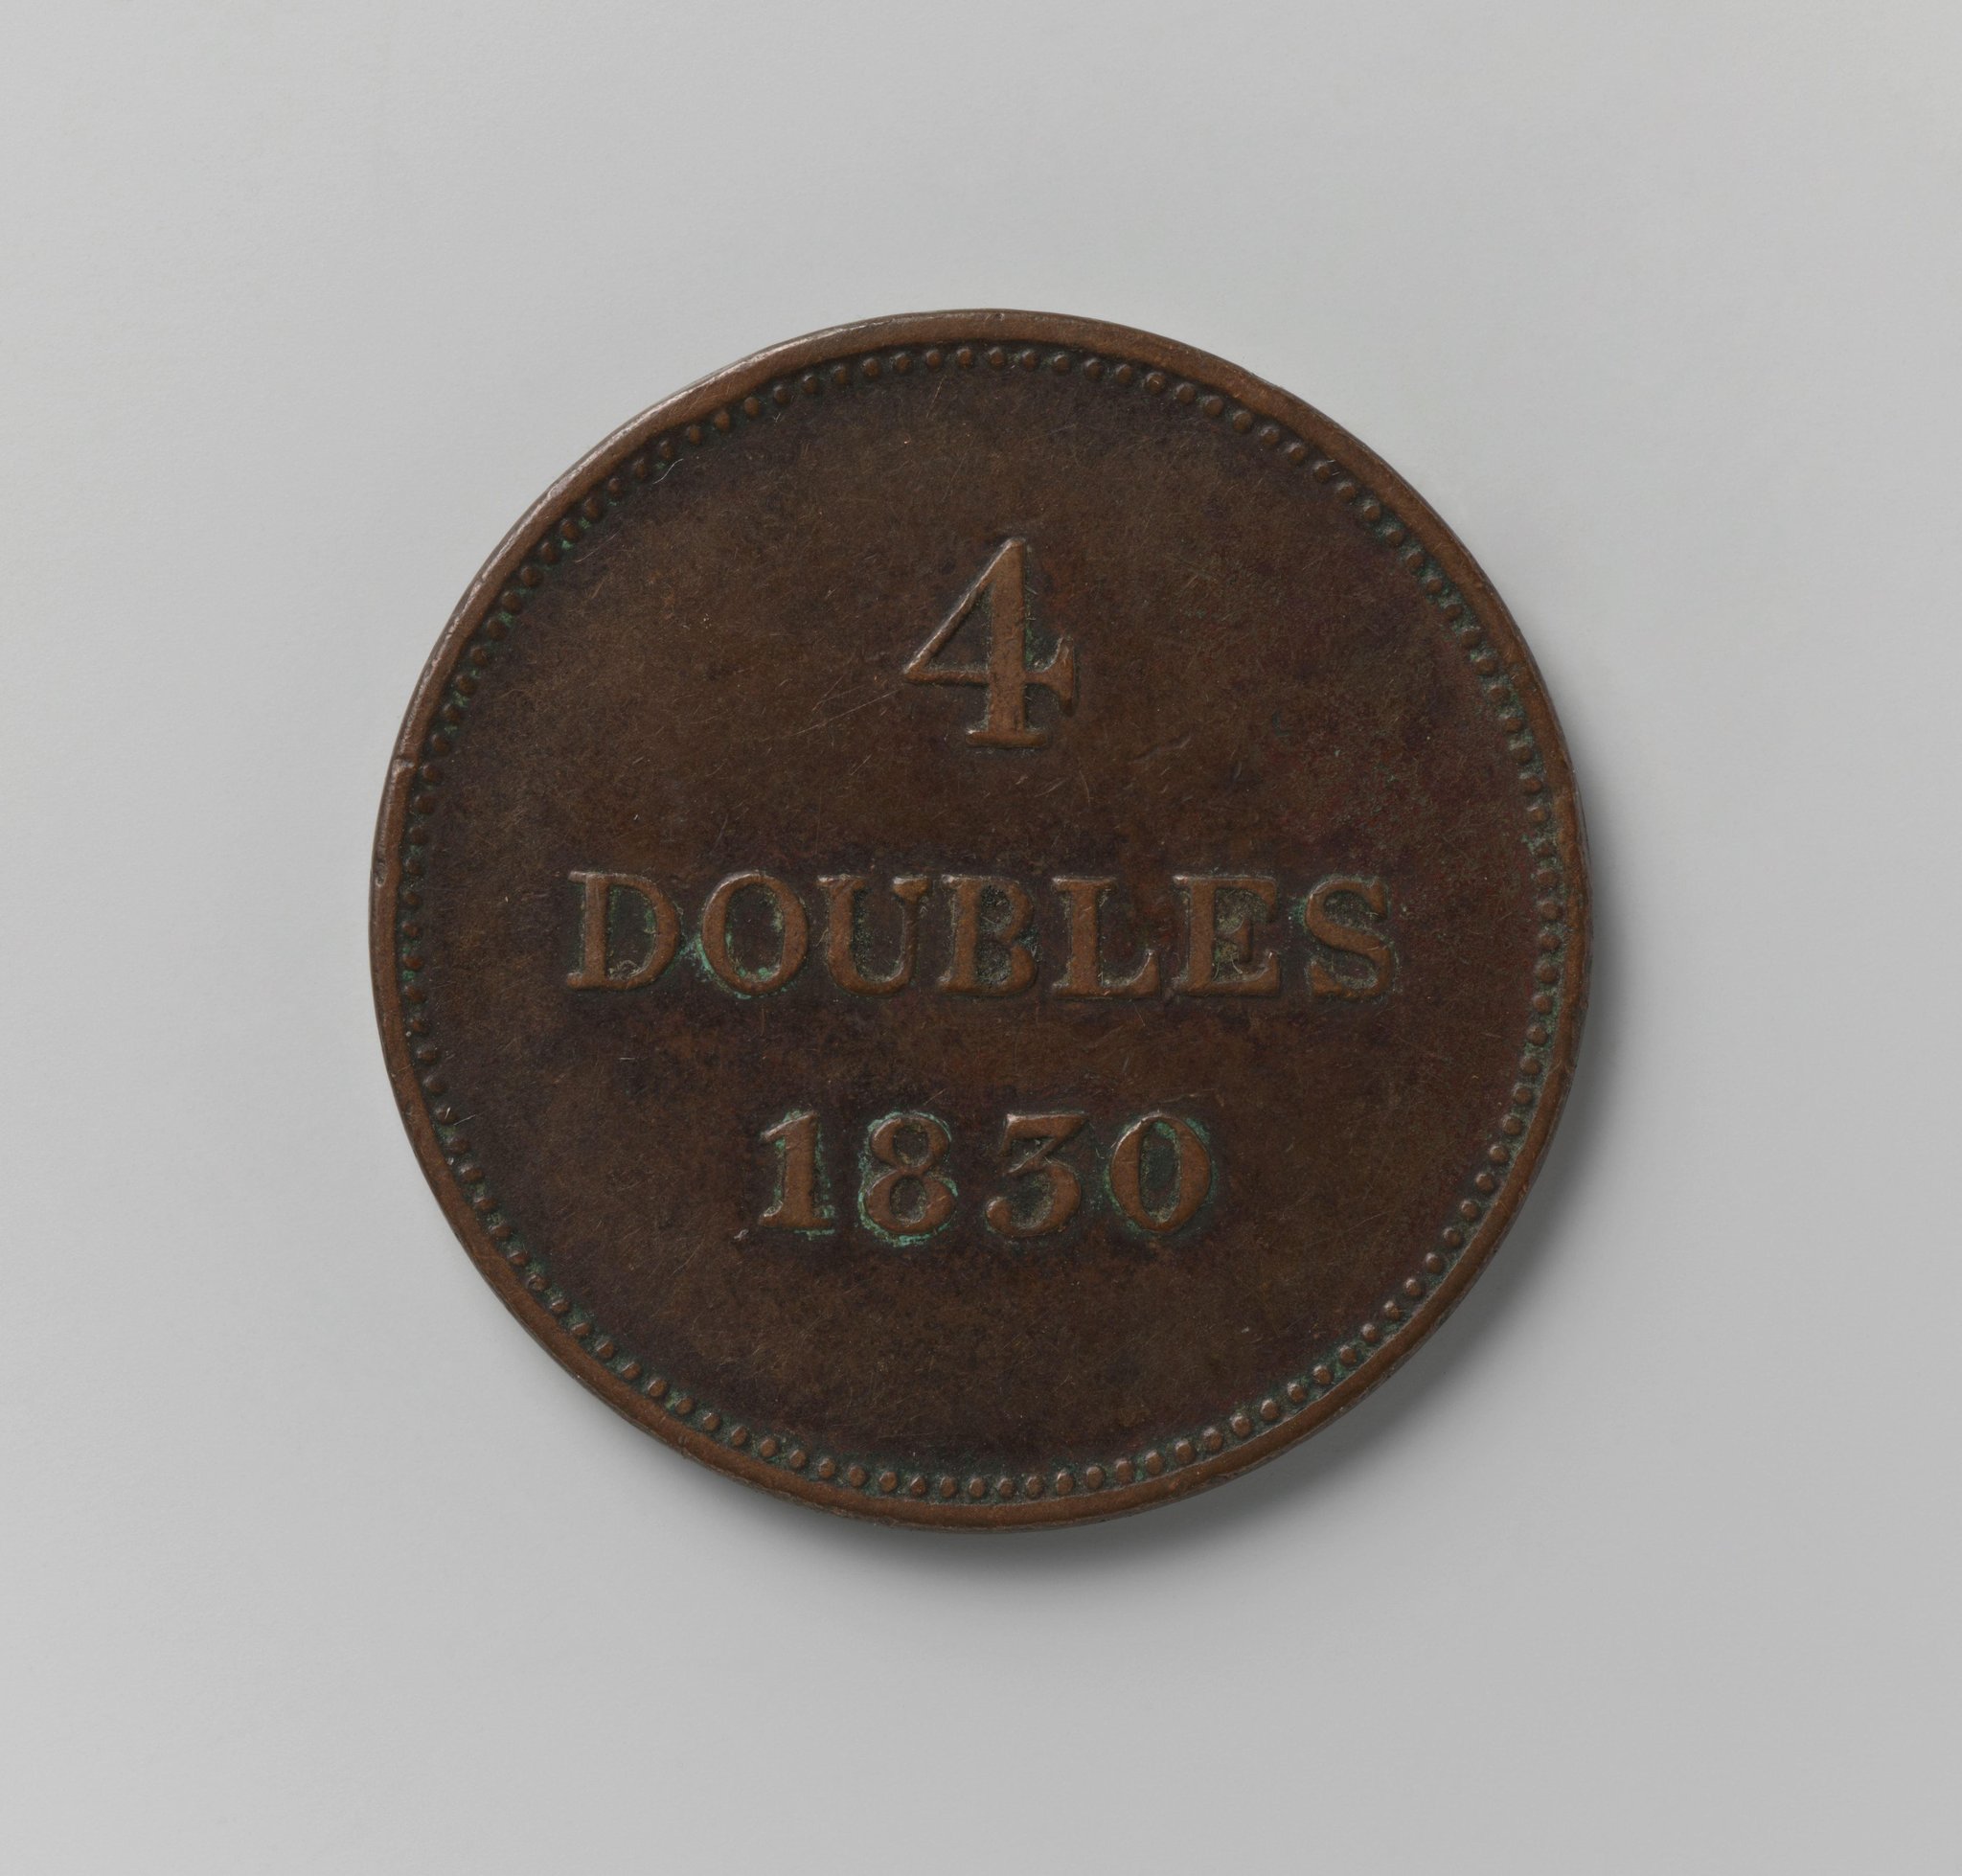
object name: coin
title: 4 doubles uit Guernsey van William IV, 1830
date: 1830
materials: copper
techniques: striking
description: Koperen munt. Voorzijde: wapenschild, waaronder landsaanduiding. Keerzijde: in twee regels waarde-aanduiding, waaronder jaartal. Gladde rand.